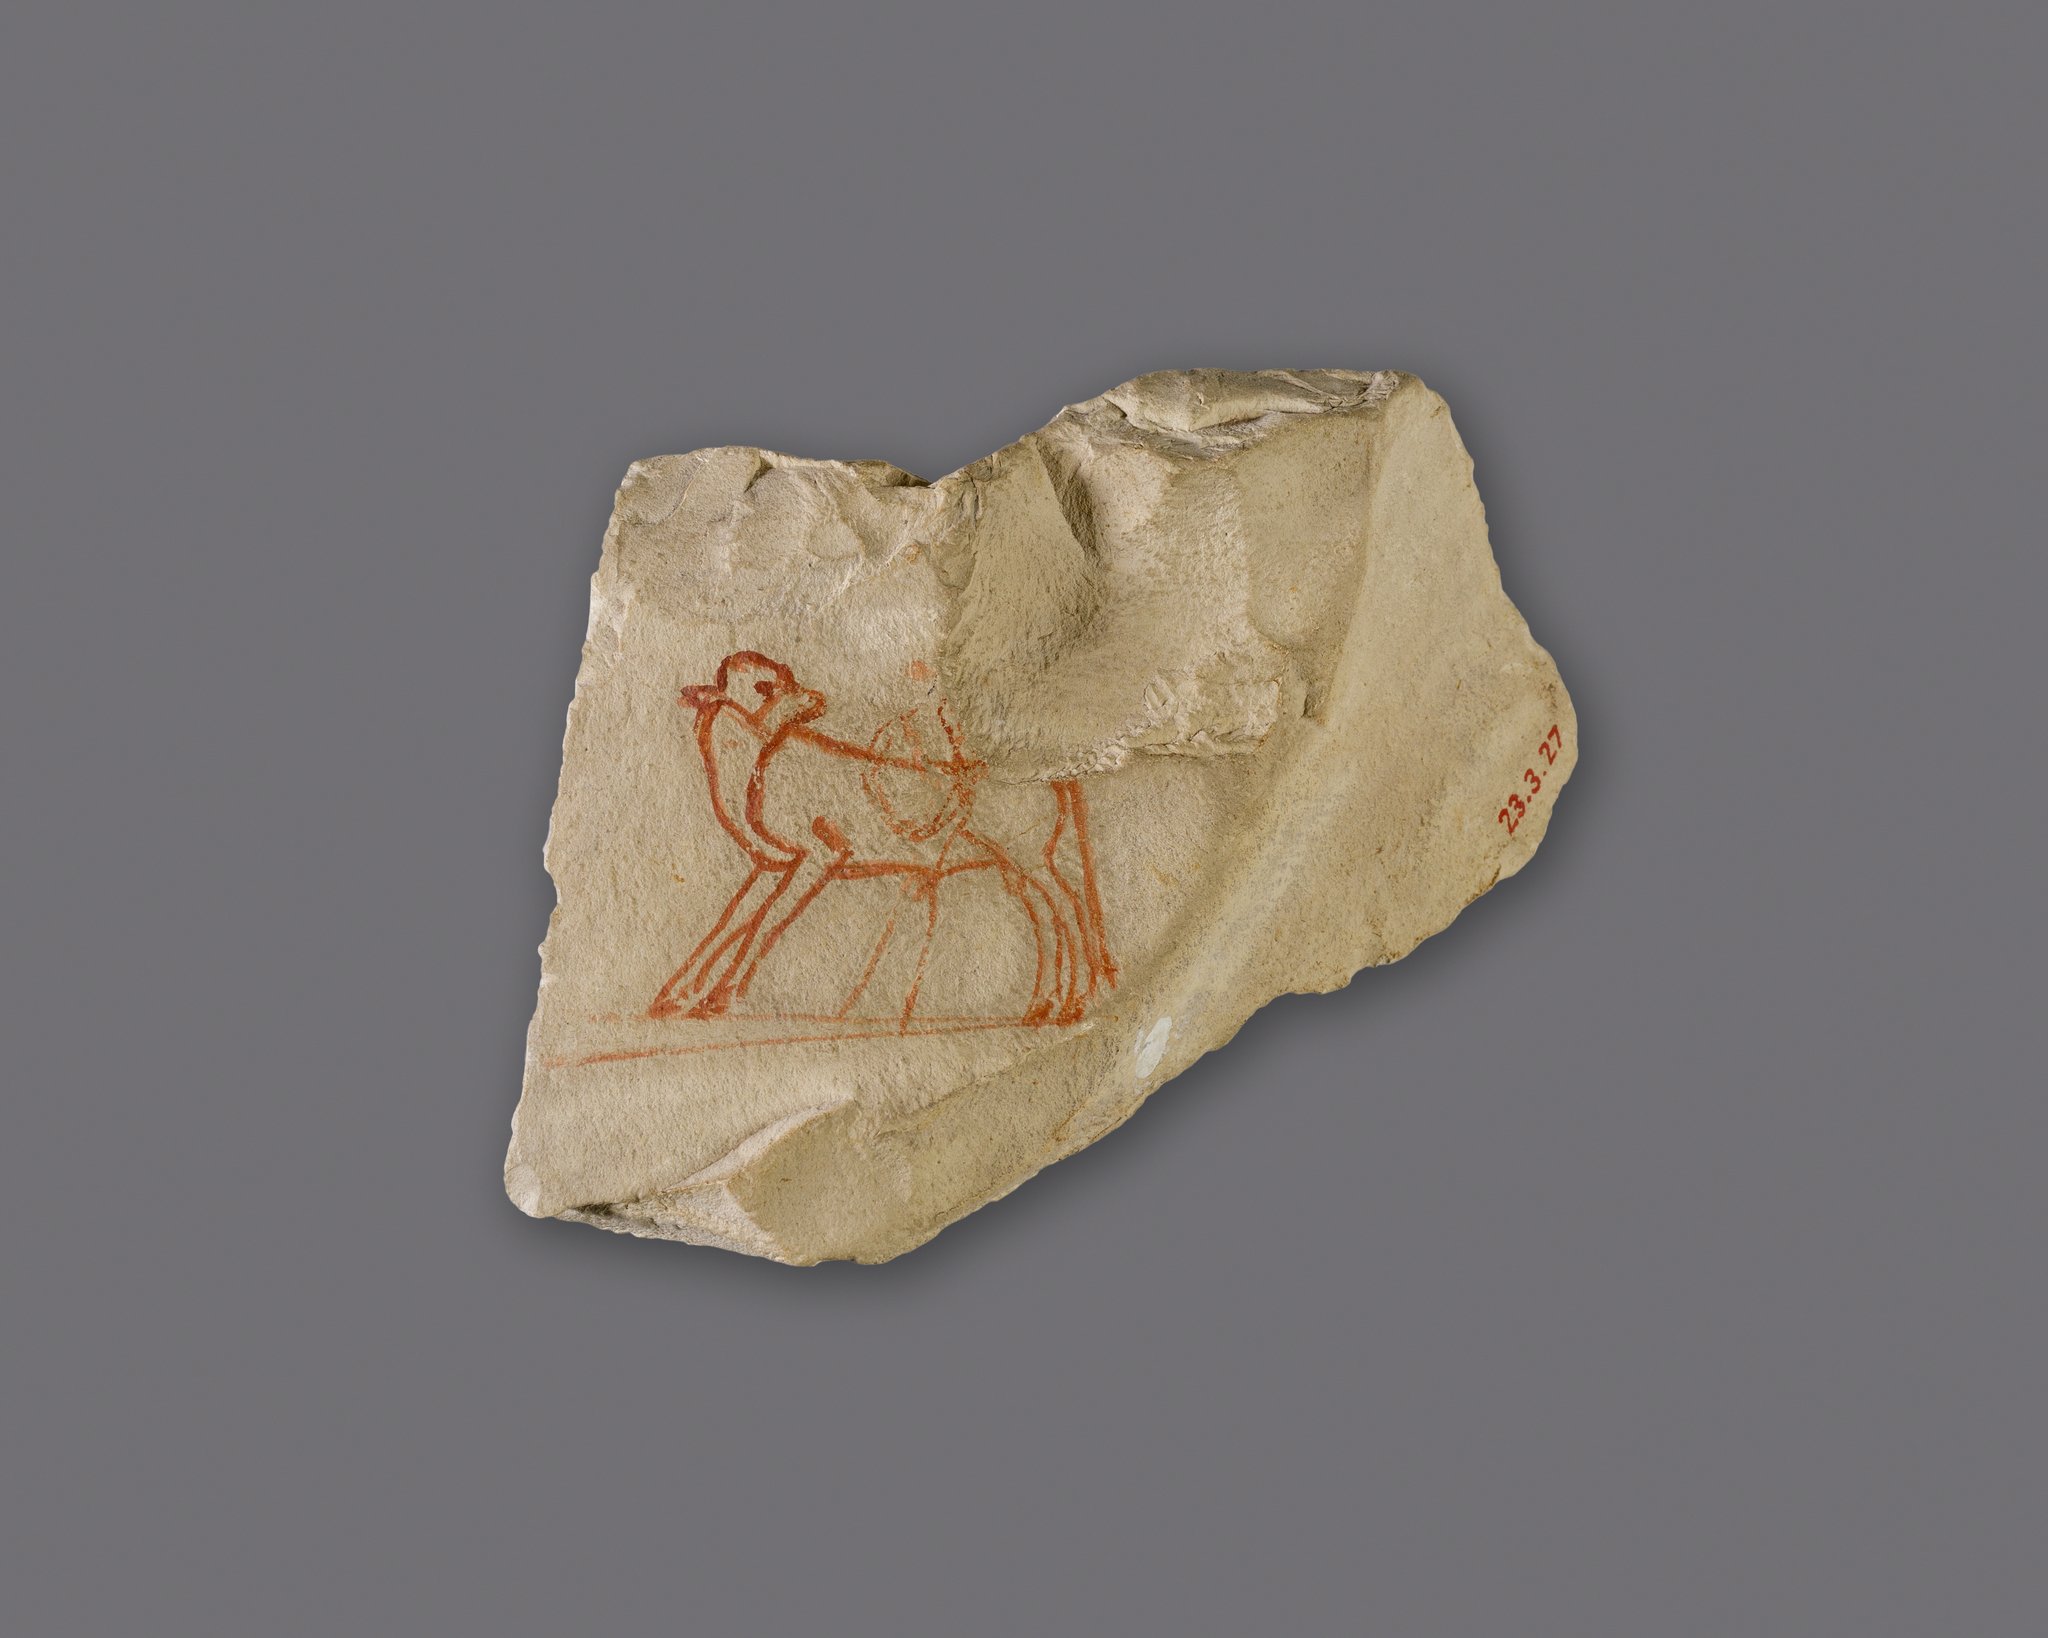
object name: ostracon, figured, calf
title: Ostracon with sketch of a calf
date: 664-610 BCE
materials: ink, limestone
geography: egypt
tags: animals